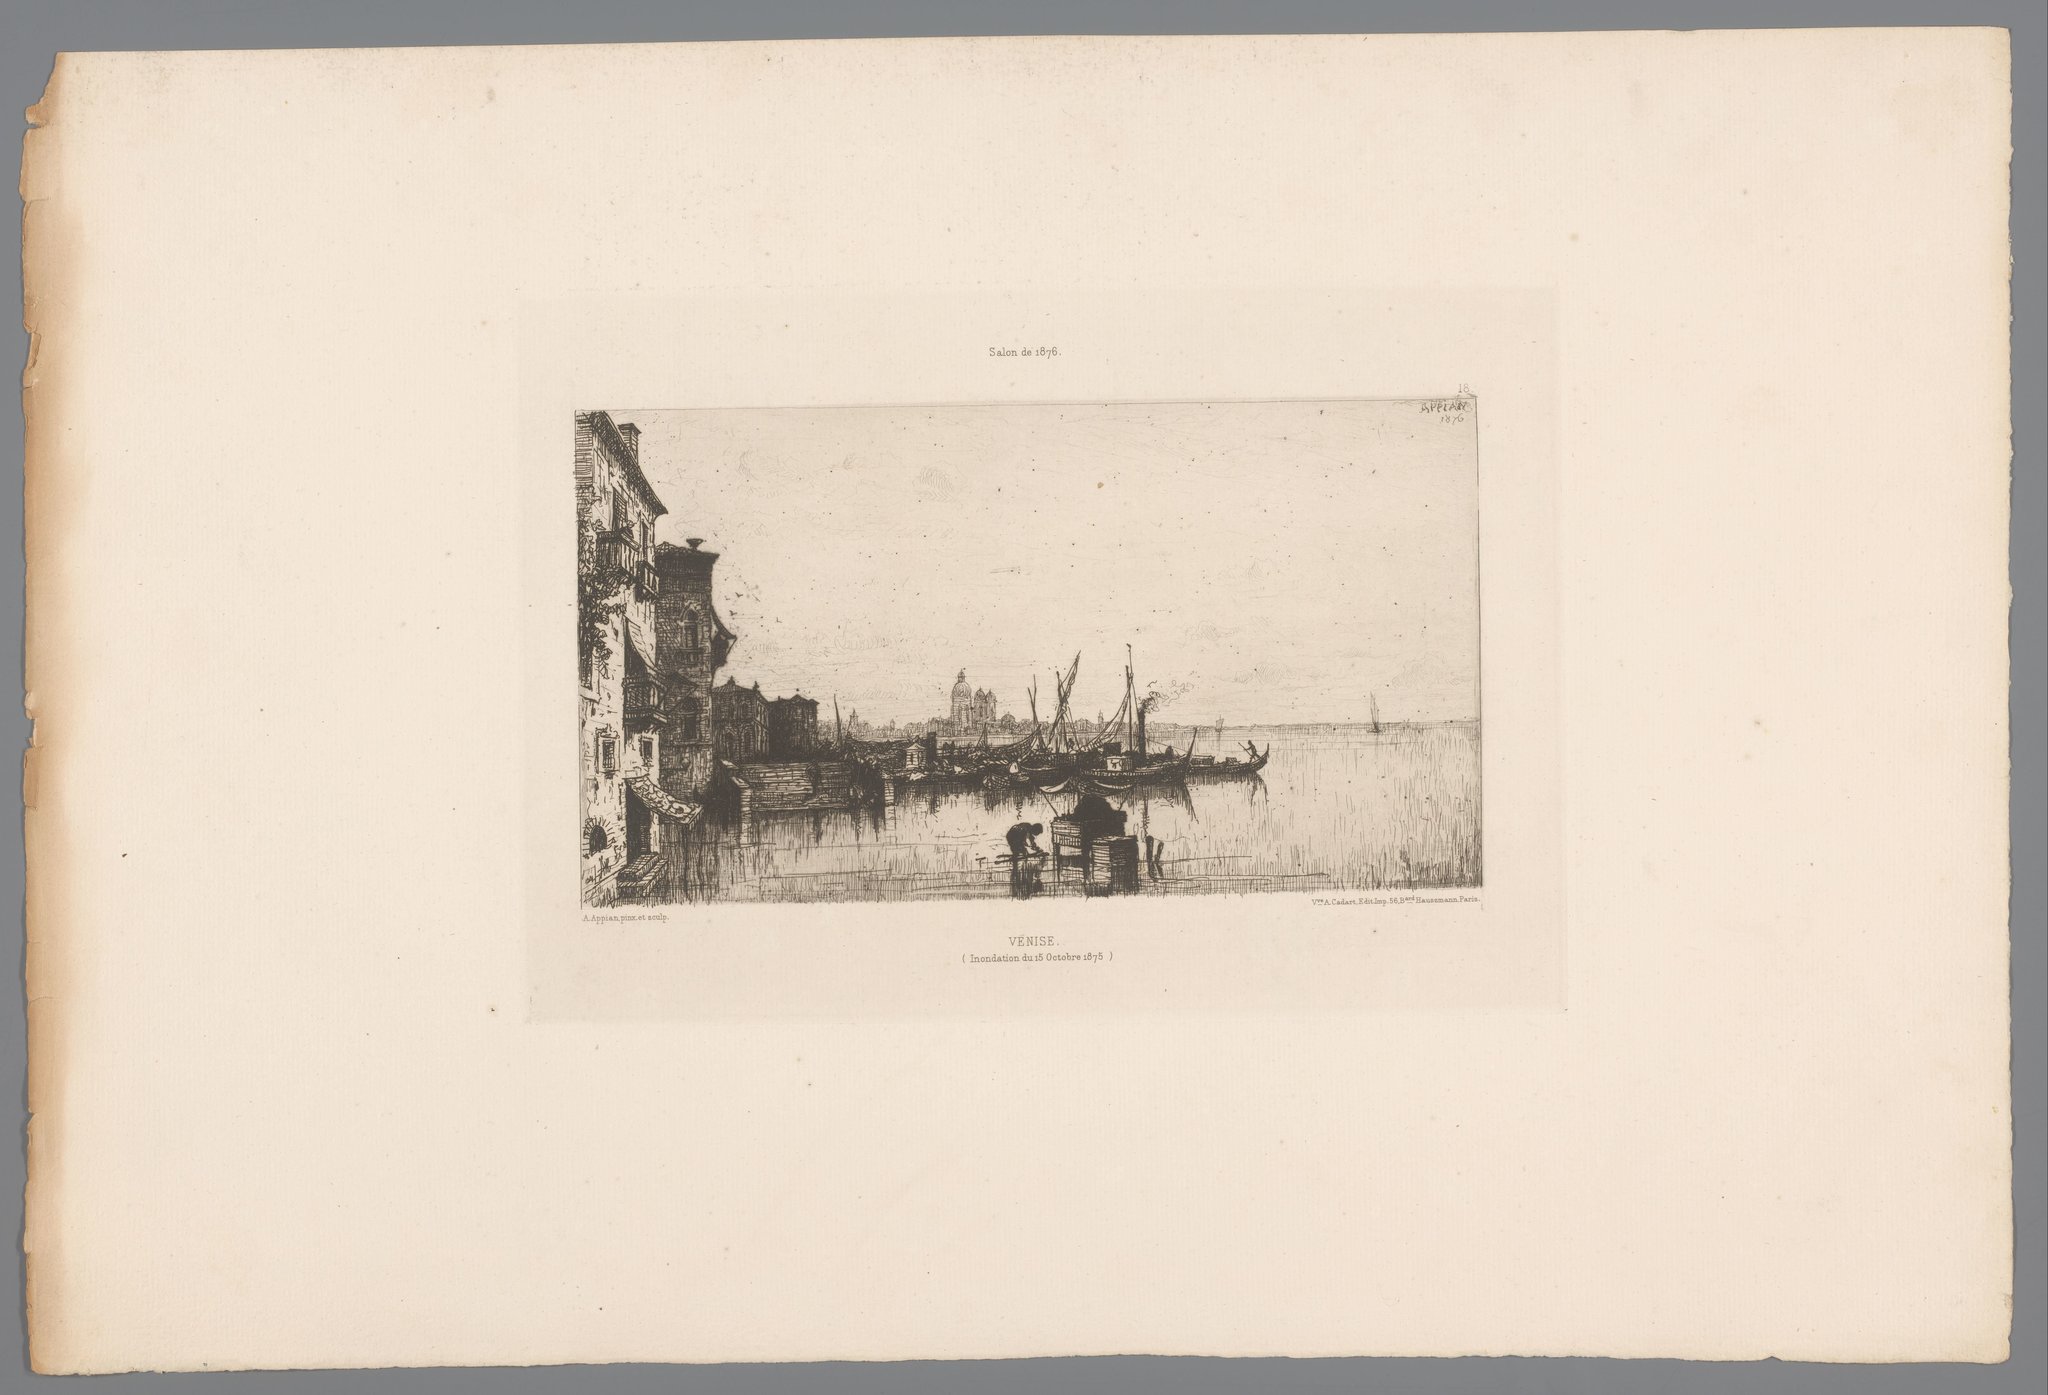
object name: print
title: Gezicht op Venetië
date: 1877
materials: paper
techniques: drypoint, etching, intaglio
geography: paris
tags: city-view, and landscape with man-made constructions, venice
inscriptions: collector's mark: Lugt 2228, collector's mark: Lugt 2760, collector's mark: ‘AFE v S’